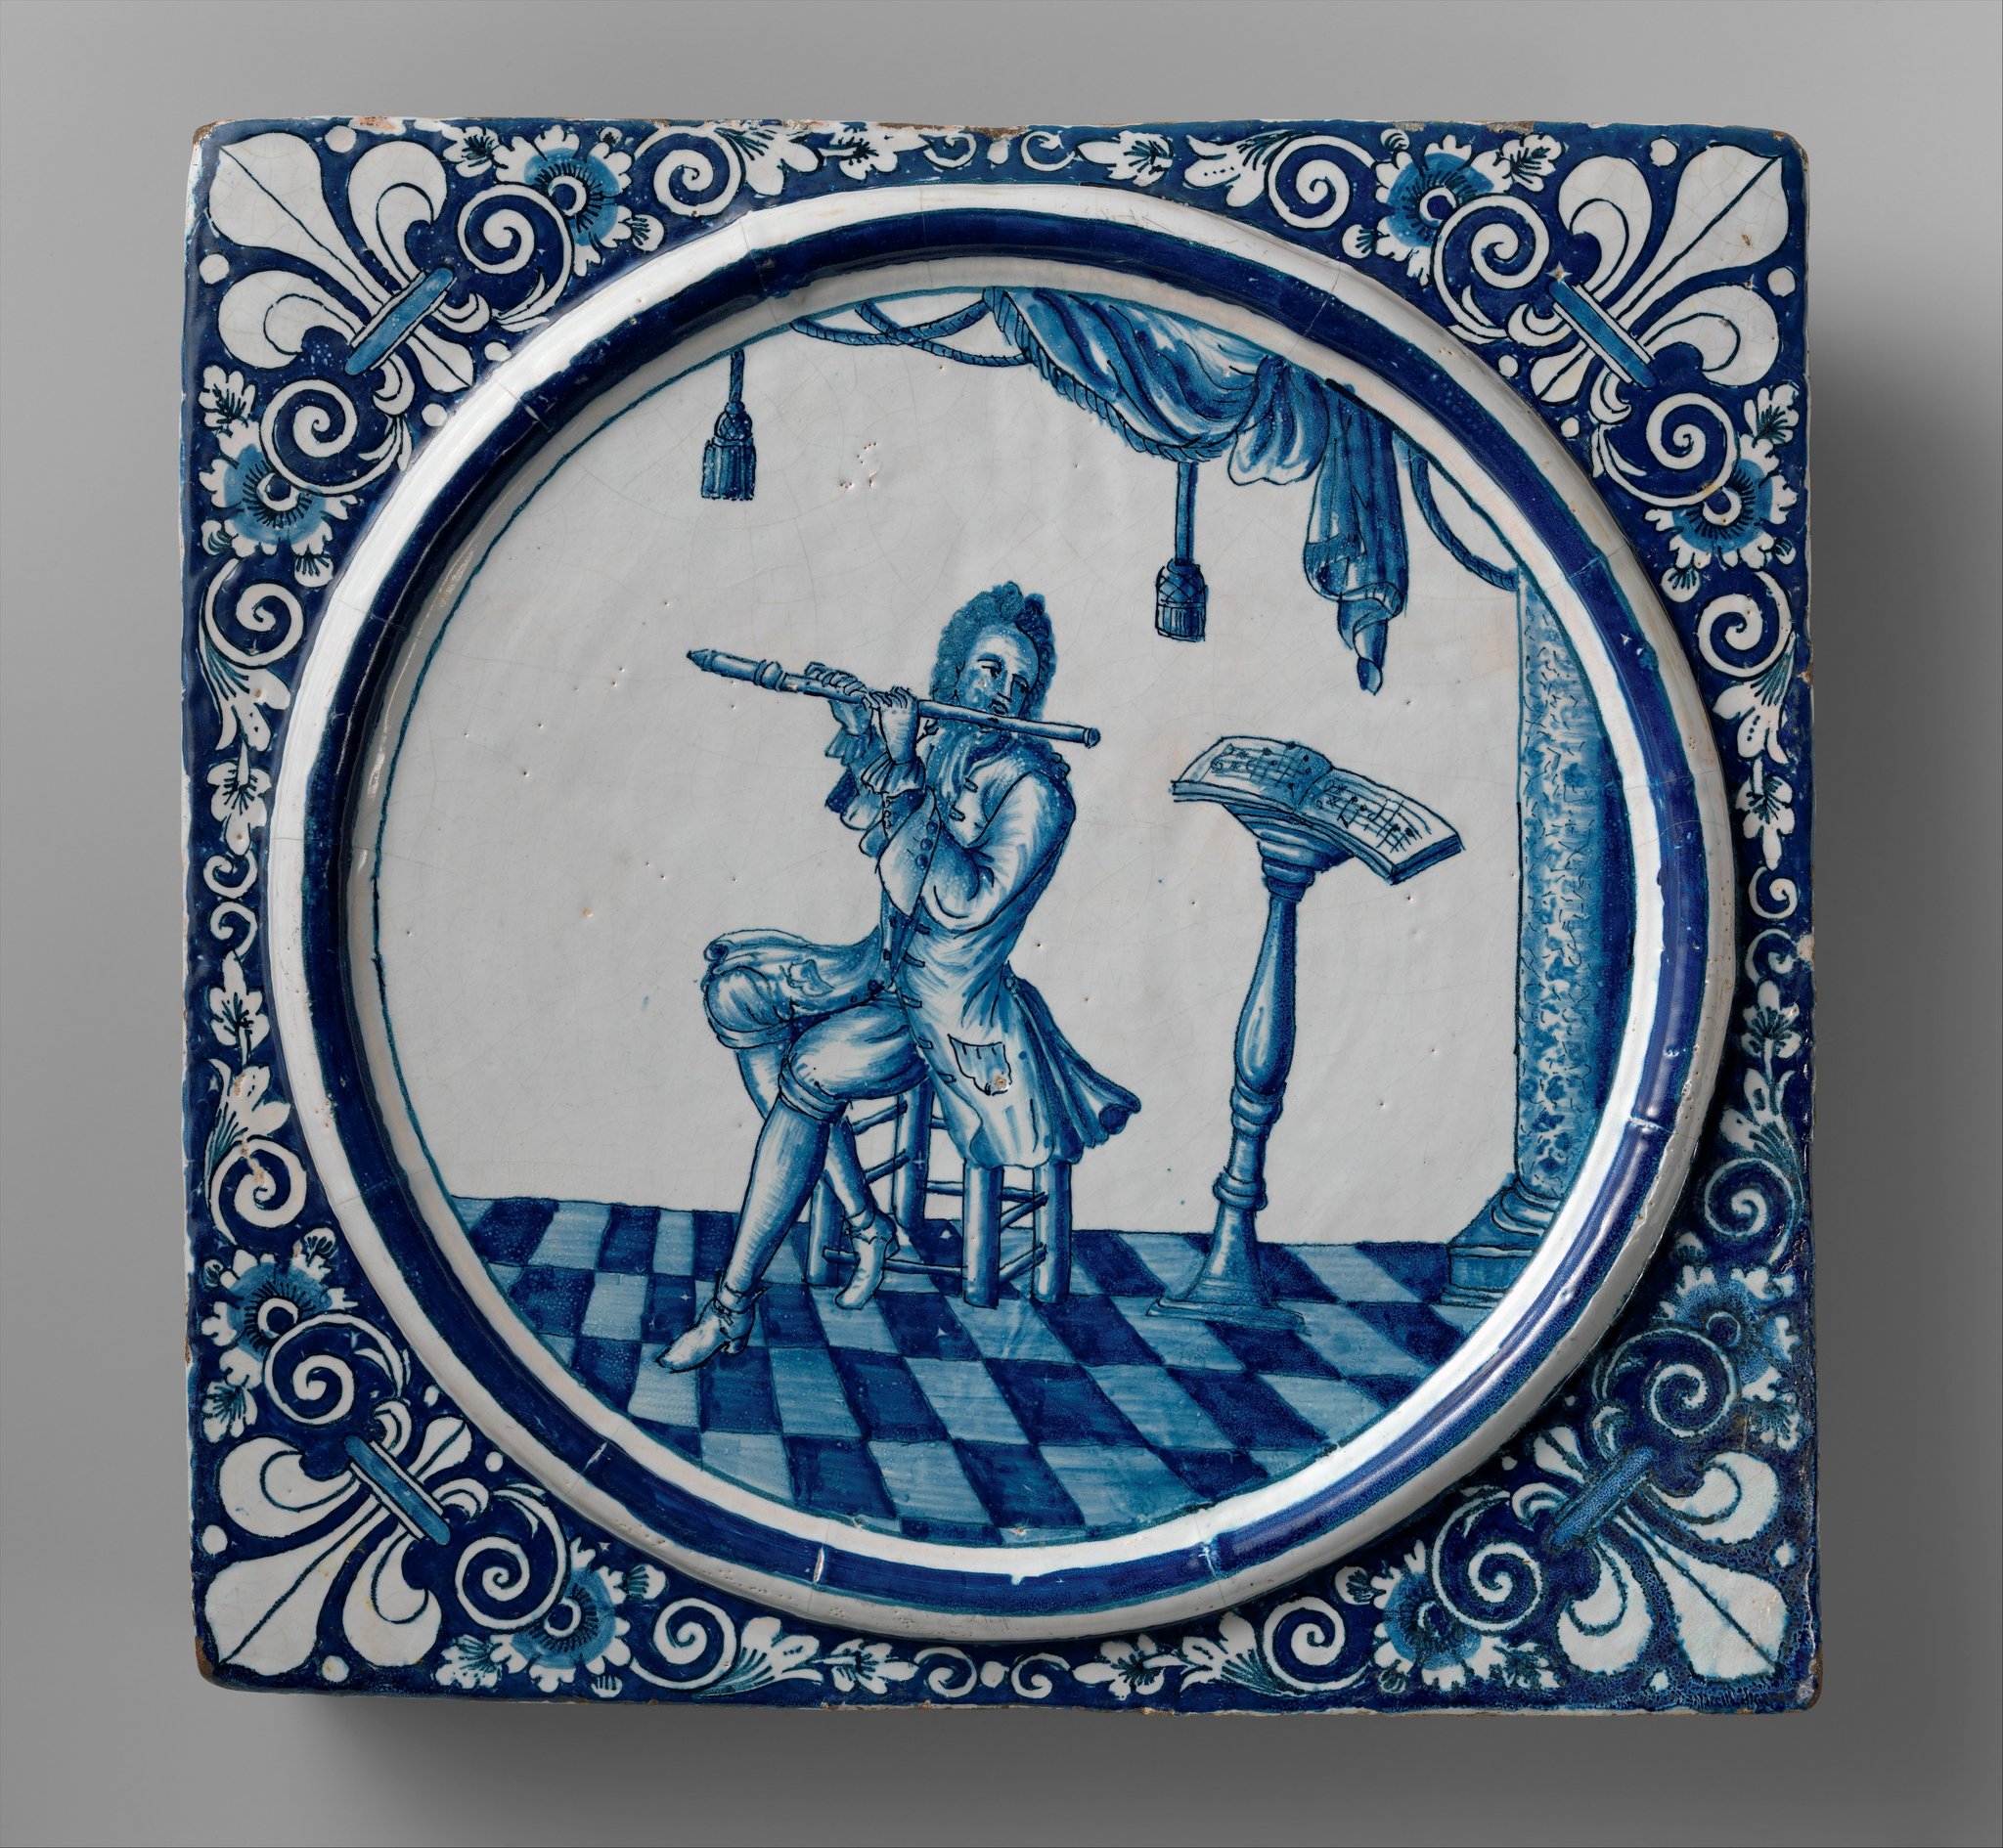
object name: tile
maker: pierre chapelle i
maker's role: artist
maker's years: 1673-1707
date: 1706-1707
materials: faience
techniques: glazing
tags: men,music,flutes